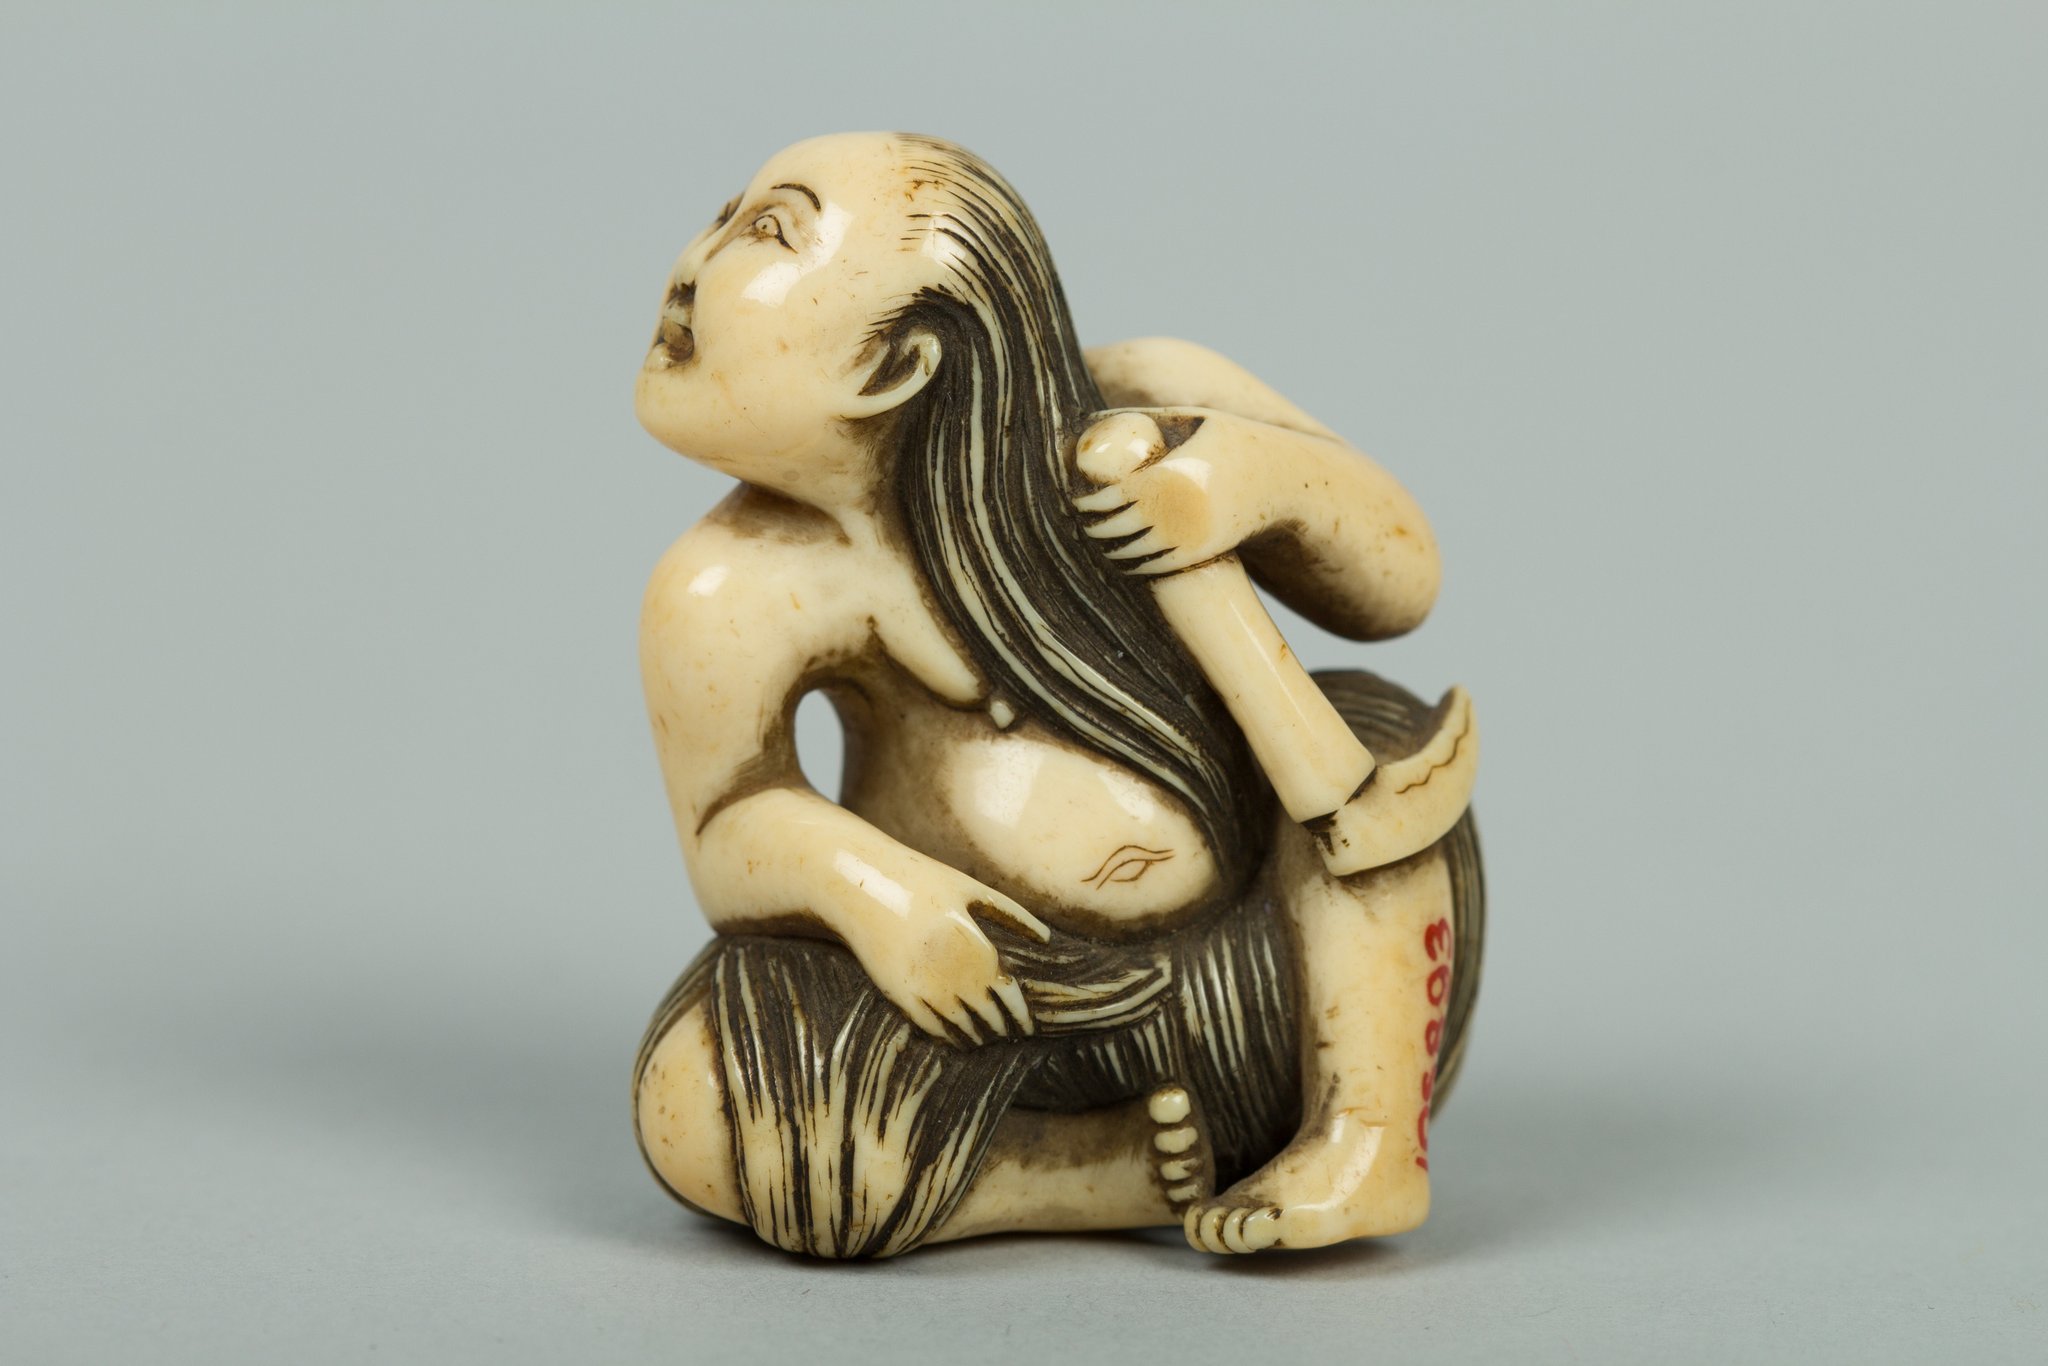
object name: netsuke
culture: japanese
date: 1801-1900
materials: ivory